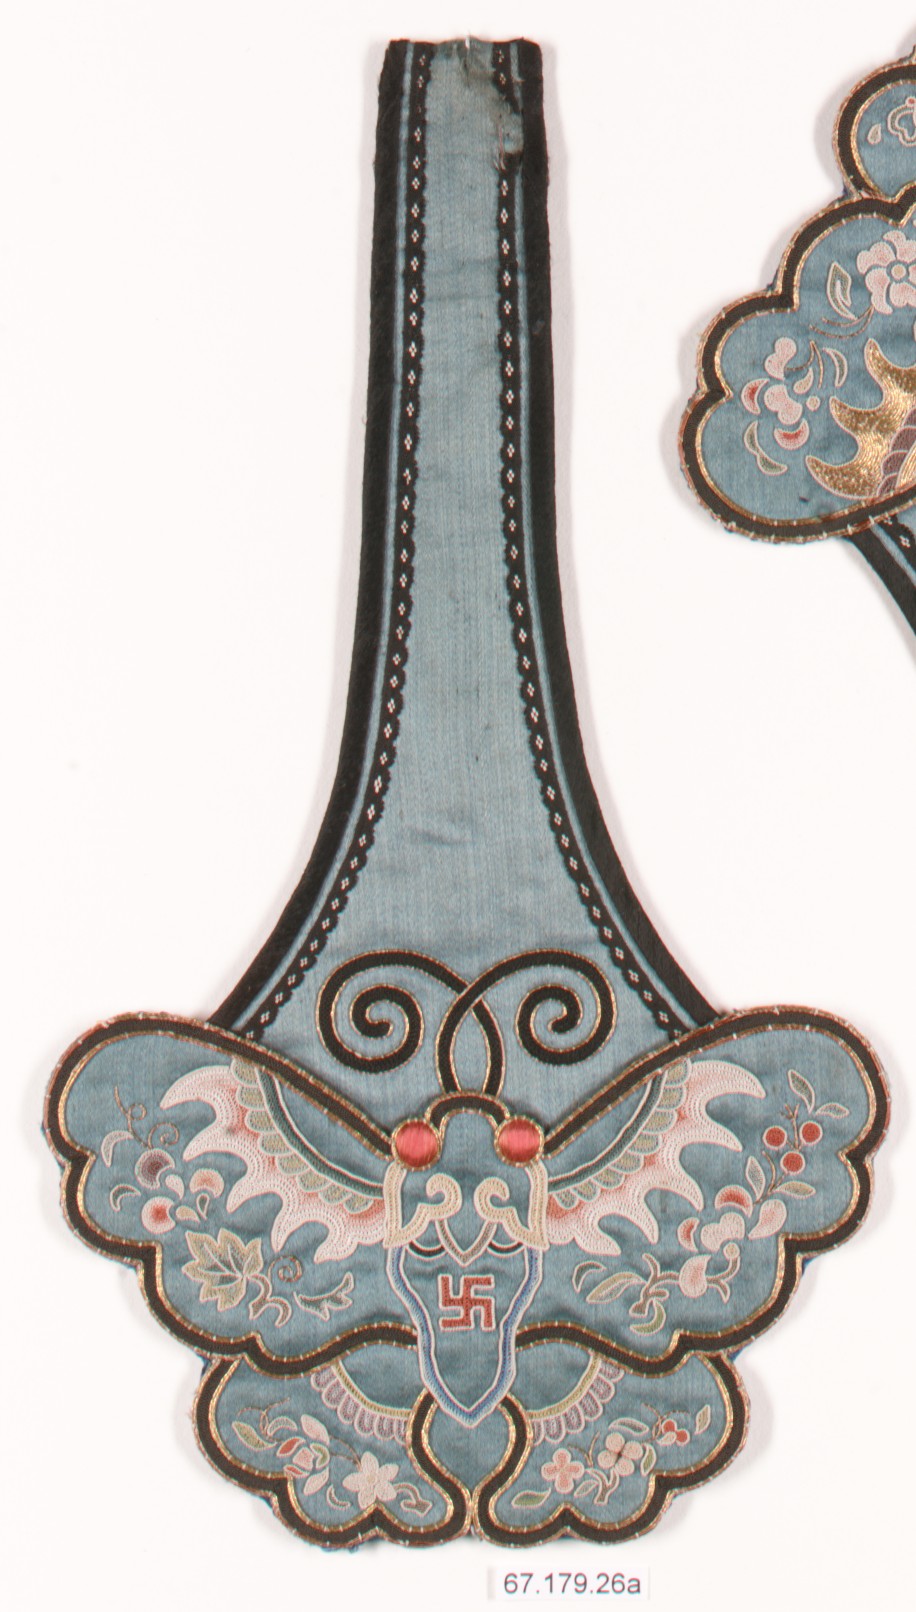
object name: appendage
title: Appendages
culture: chinese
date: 1801-1900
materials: metal thread, silk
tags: butterflies,flowers